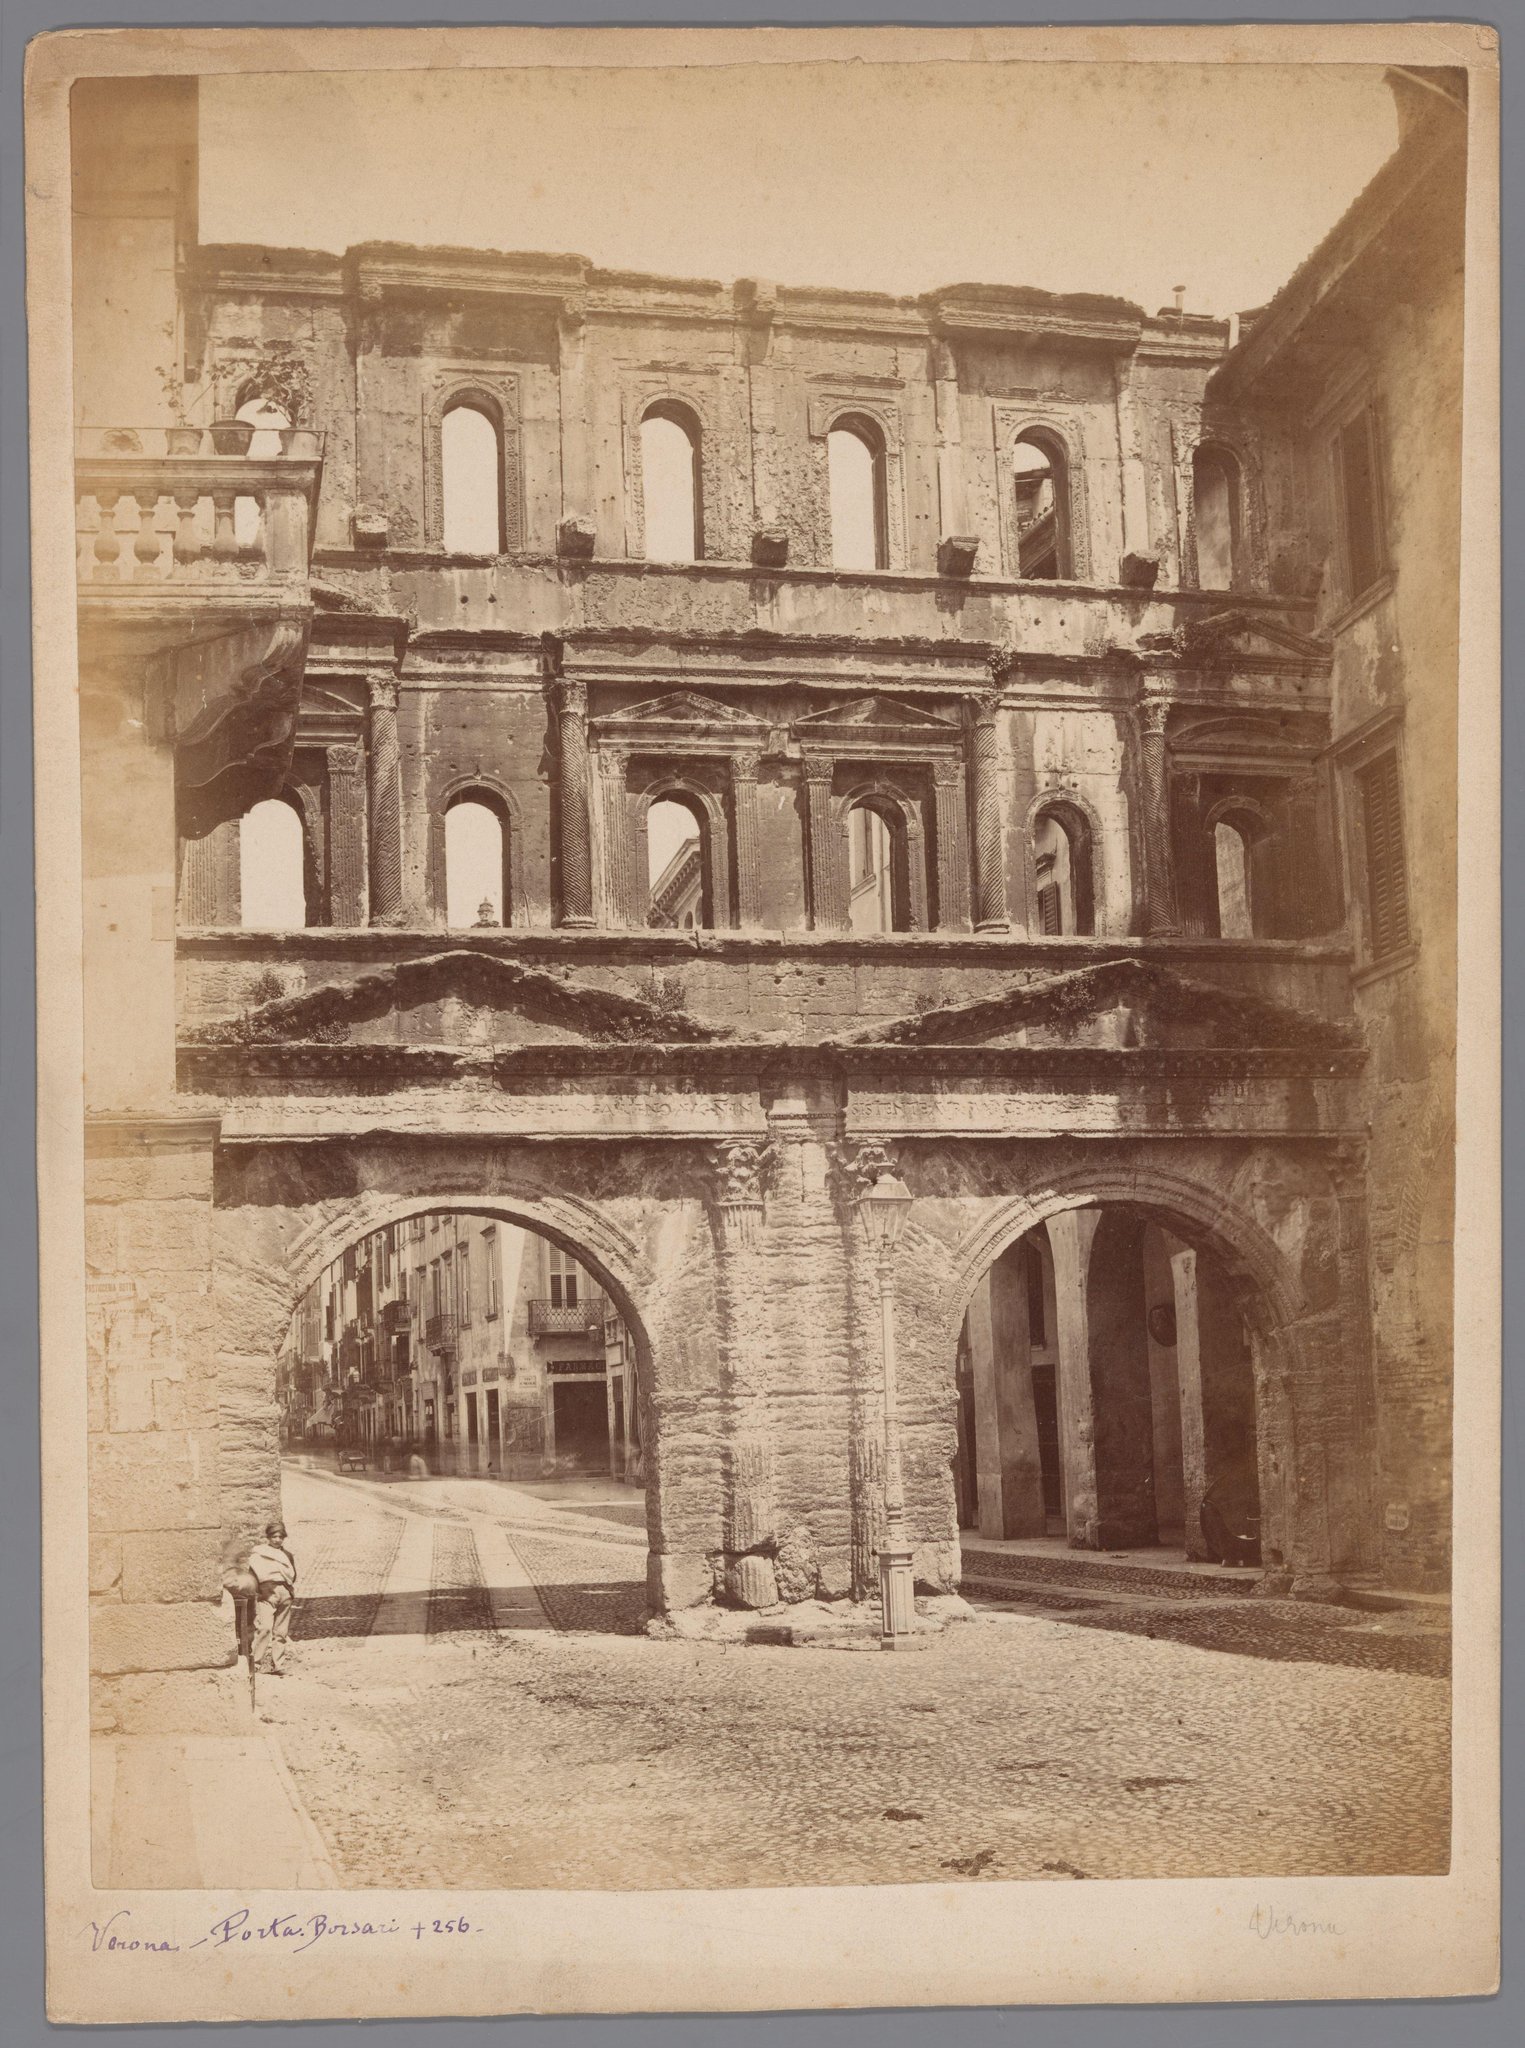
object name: photograph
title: Porta Borsari te Verona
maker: Anonymous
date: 1851-1900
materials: cardboard, paper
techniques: albumen print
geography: verona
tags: gate, entrance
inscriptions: inscription: ‘Verona’